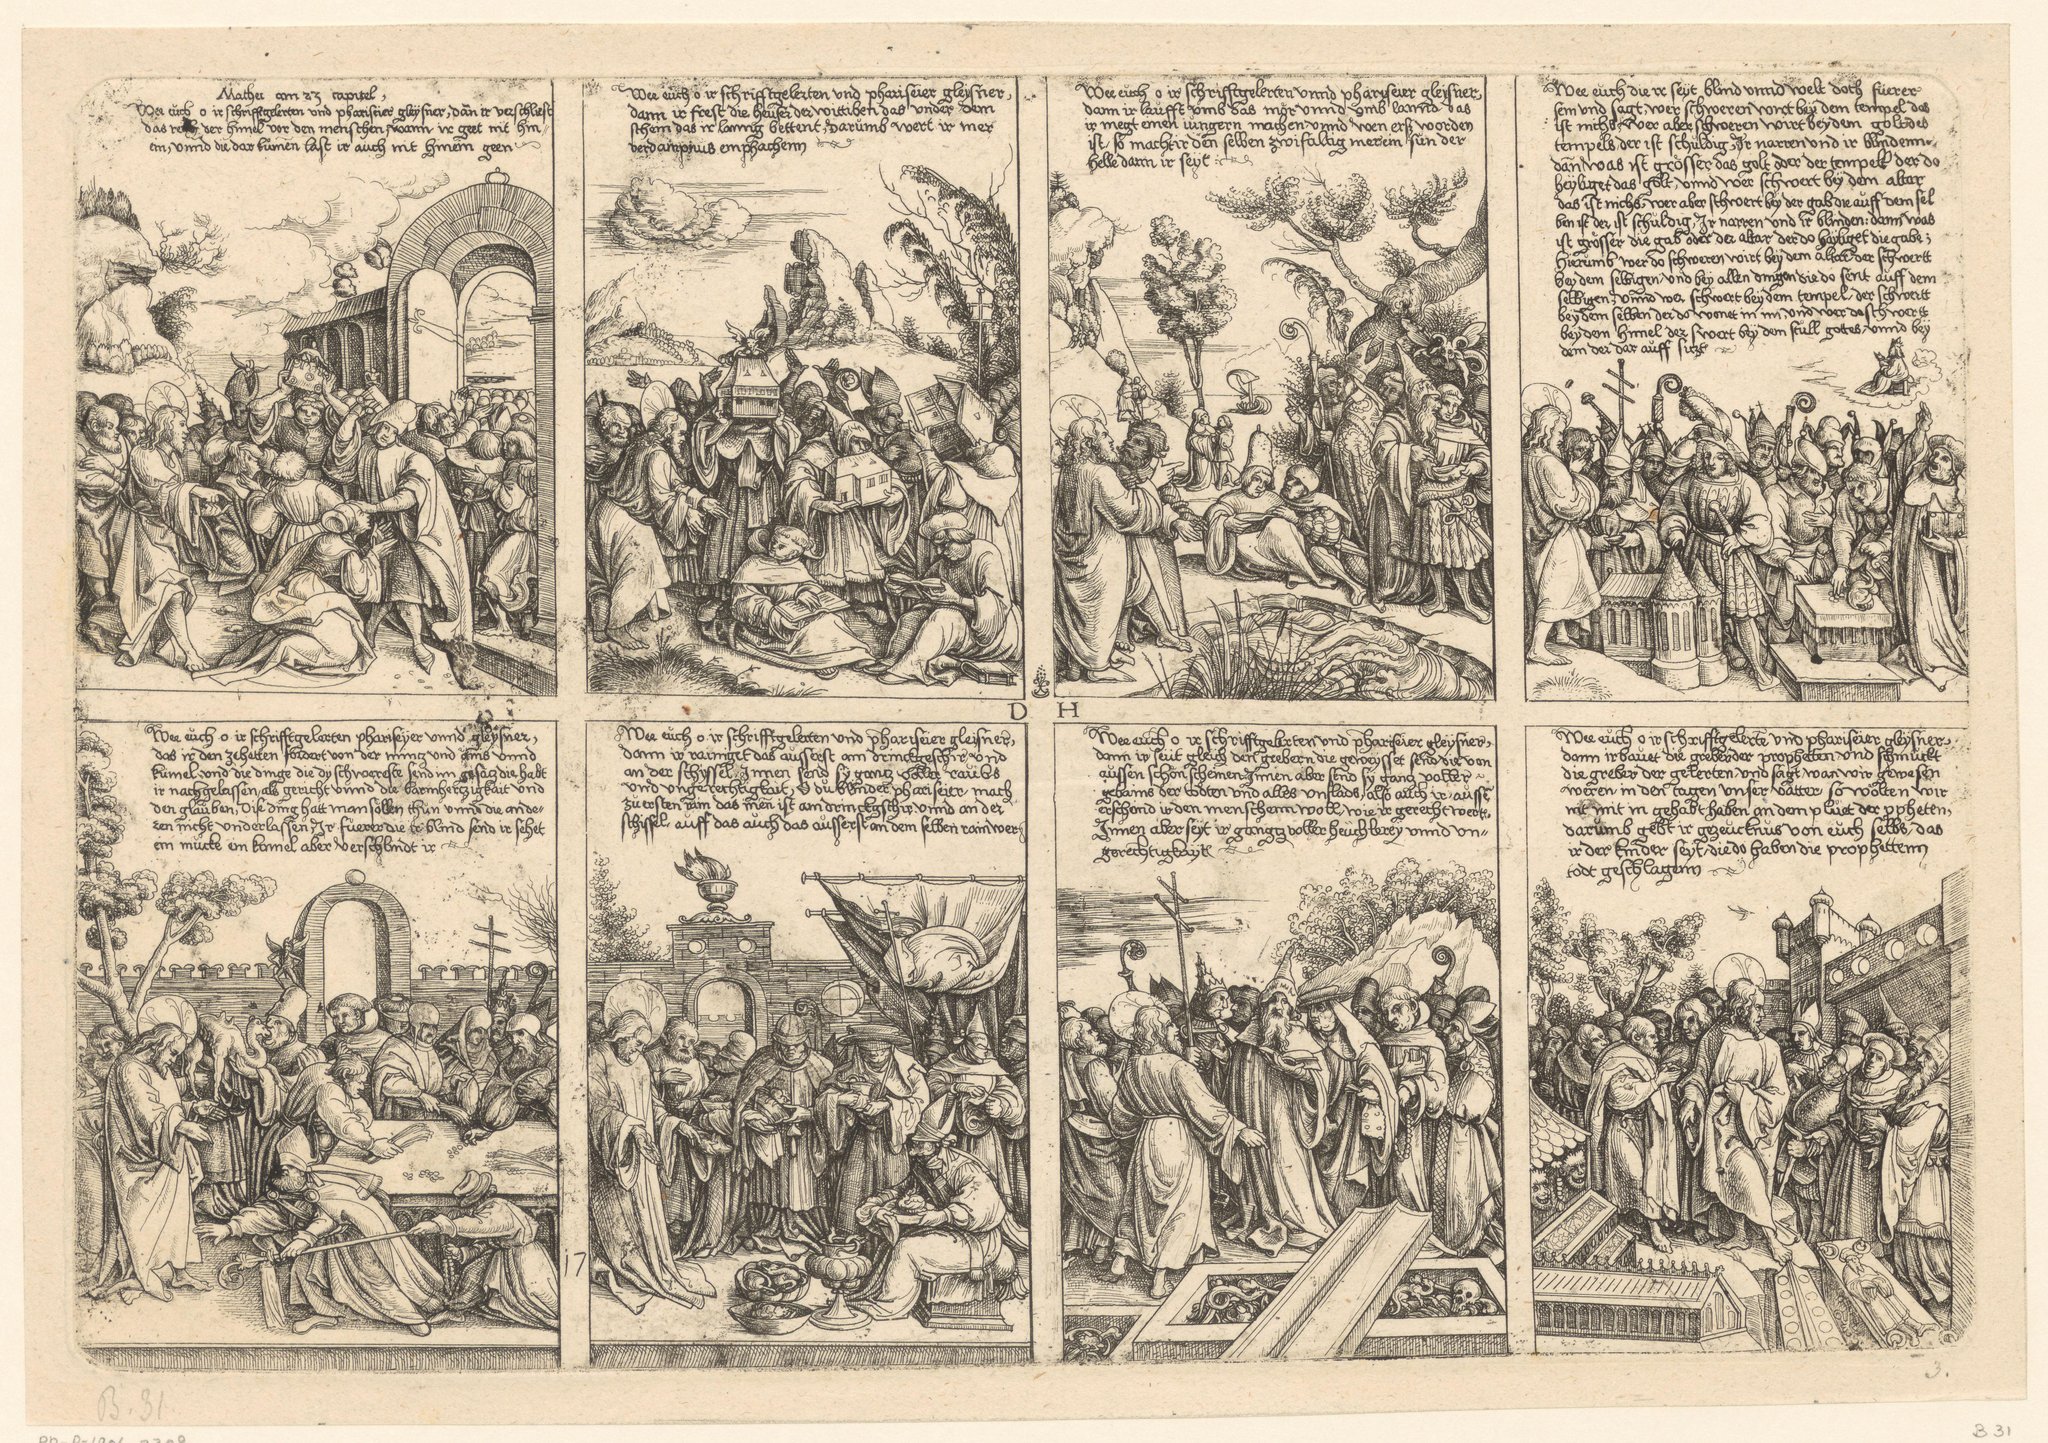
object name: print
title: Christus veroordeelt de schriftgeleerden en Farizeeën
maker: daniel hopfer (i)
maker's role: print maker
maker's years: 1470-1536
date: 1505-1536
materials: paper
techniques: etching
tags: speeches of christ against scribes and pharisees (matthew 23; mark 12:38-40; luke 11:42-52, 20:45-47)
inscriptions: collector's mark: Lugt 2228, collector's mark: Lugt 2760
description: Acht illustraties bij de tekst uit Mat. 23:13-31 in het Duits in het Fraktur lettertype.